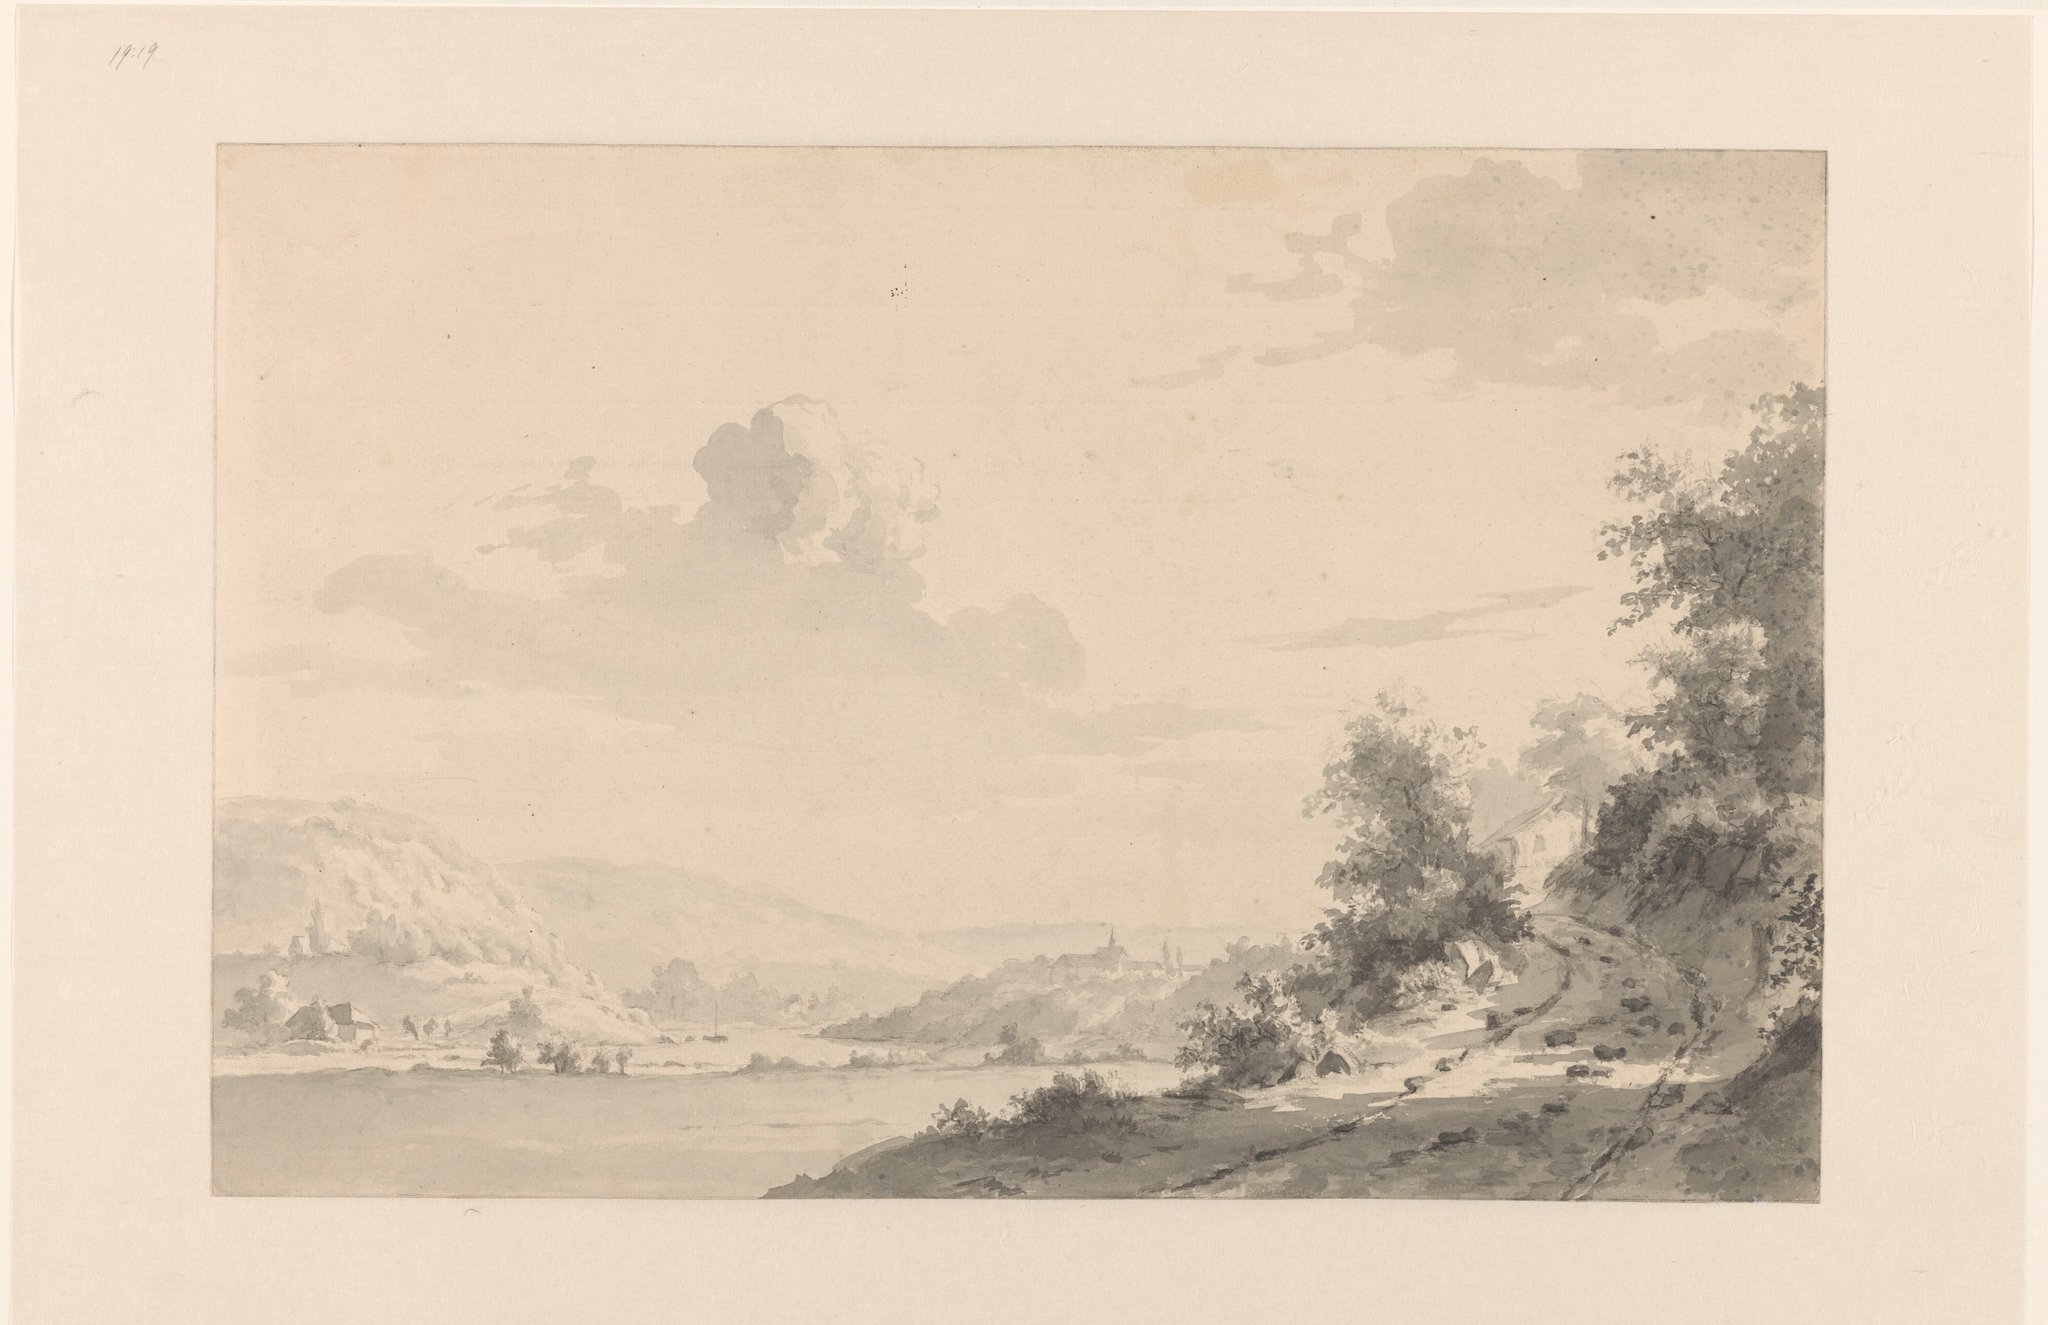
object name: drawing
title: Rivierlandschap bij Mühlheim aan de Ruhr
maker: george andries roth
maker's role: draughtsman, painter, print maker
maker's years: 1809-1887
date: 1819-1887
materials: chalk, paper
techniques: brush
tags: river